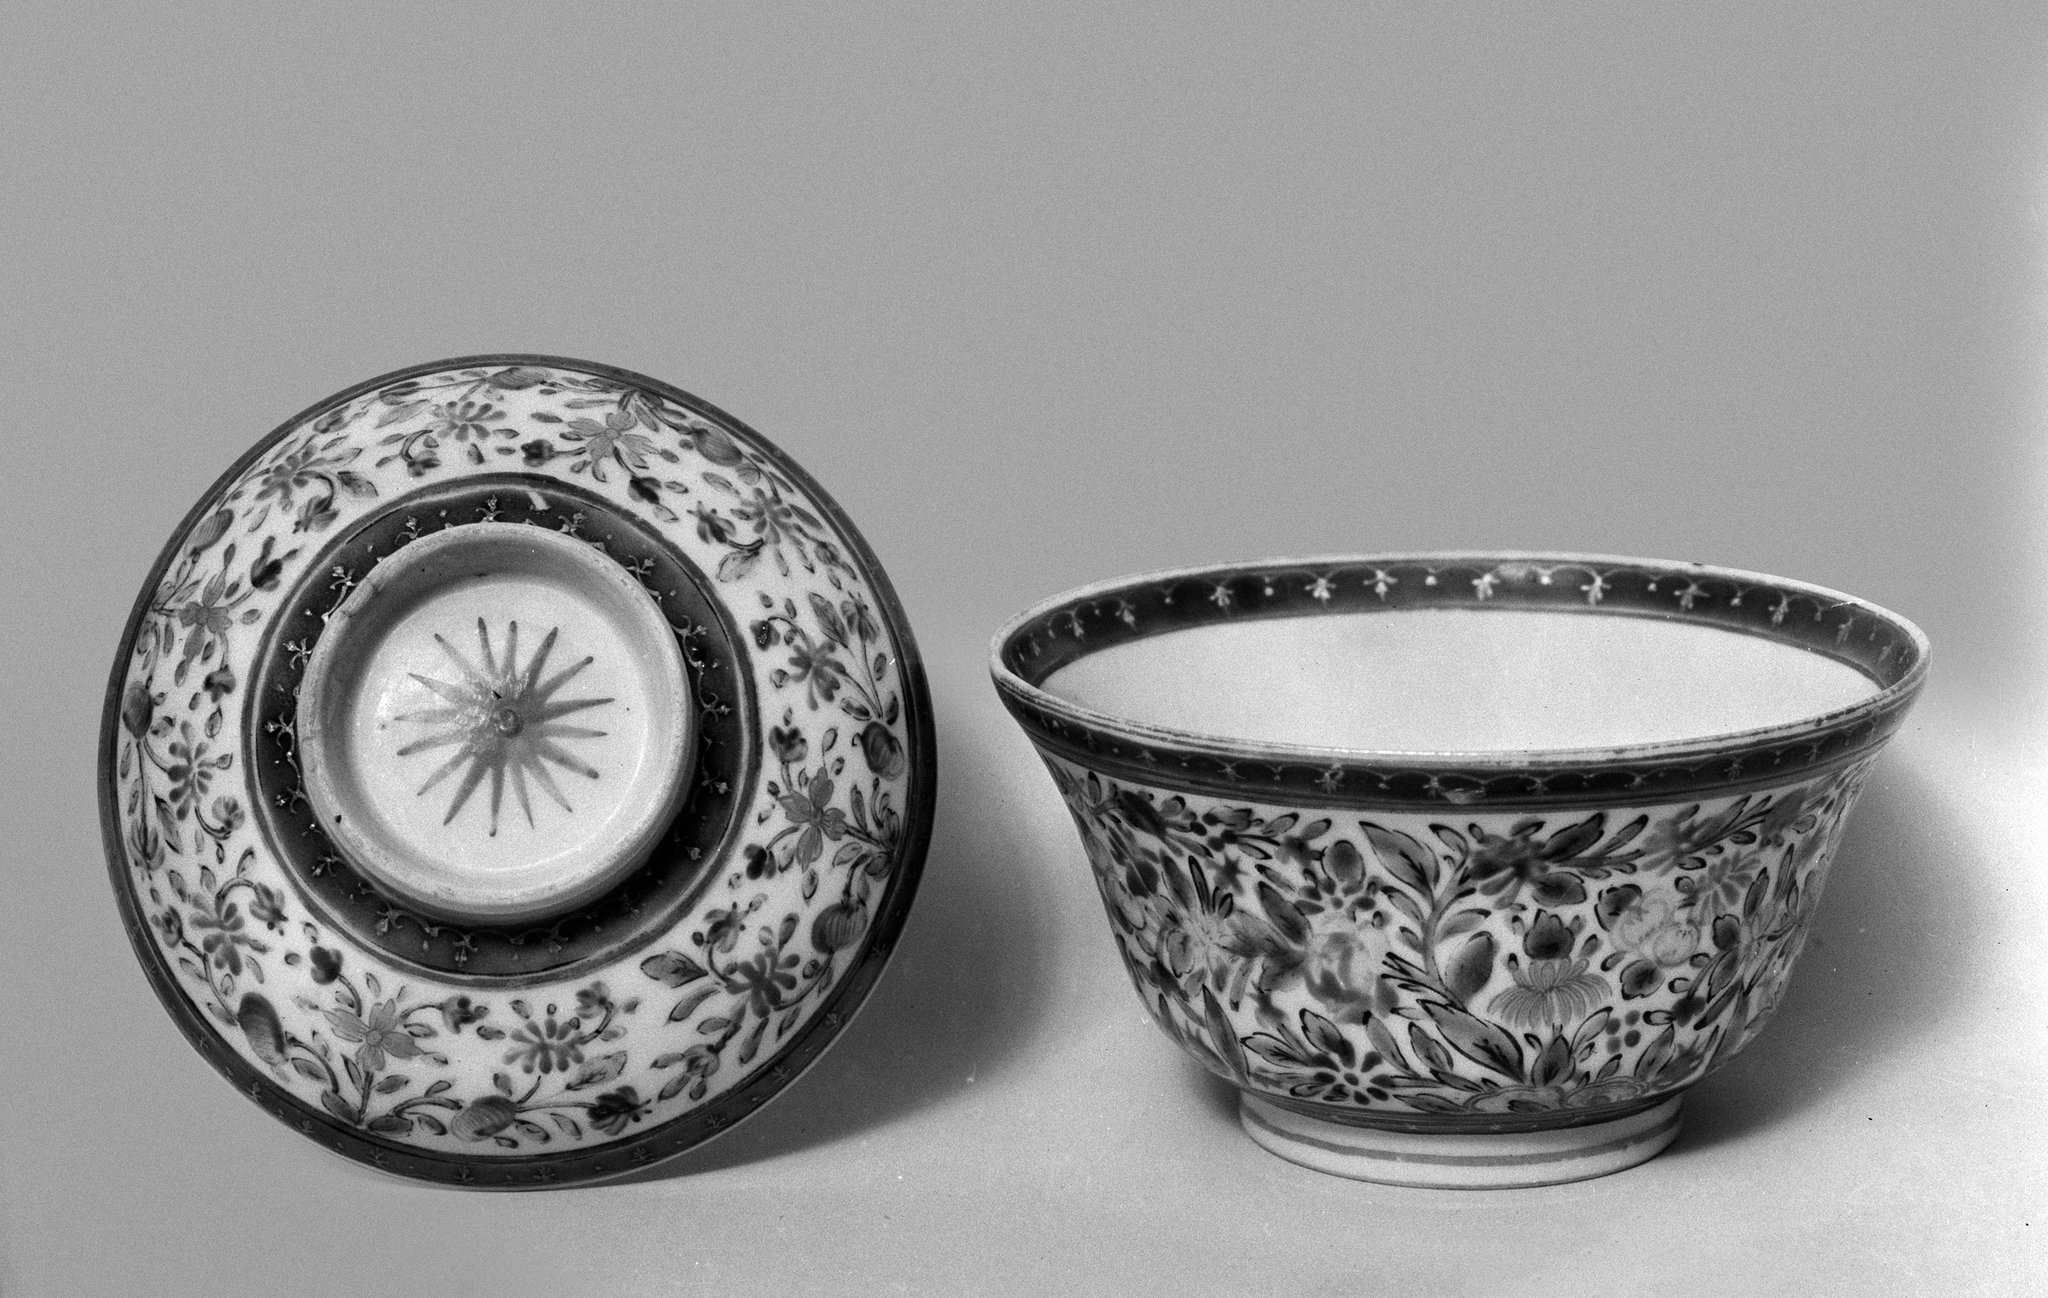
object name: covered bowl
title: Covered bowl with floral pattern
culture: chinese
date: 1801-1900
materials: enamel, porcelain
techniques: overglaze, painting, polychrome